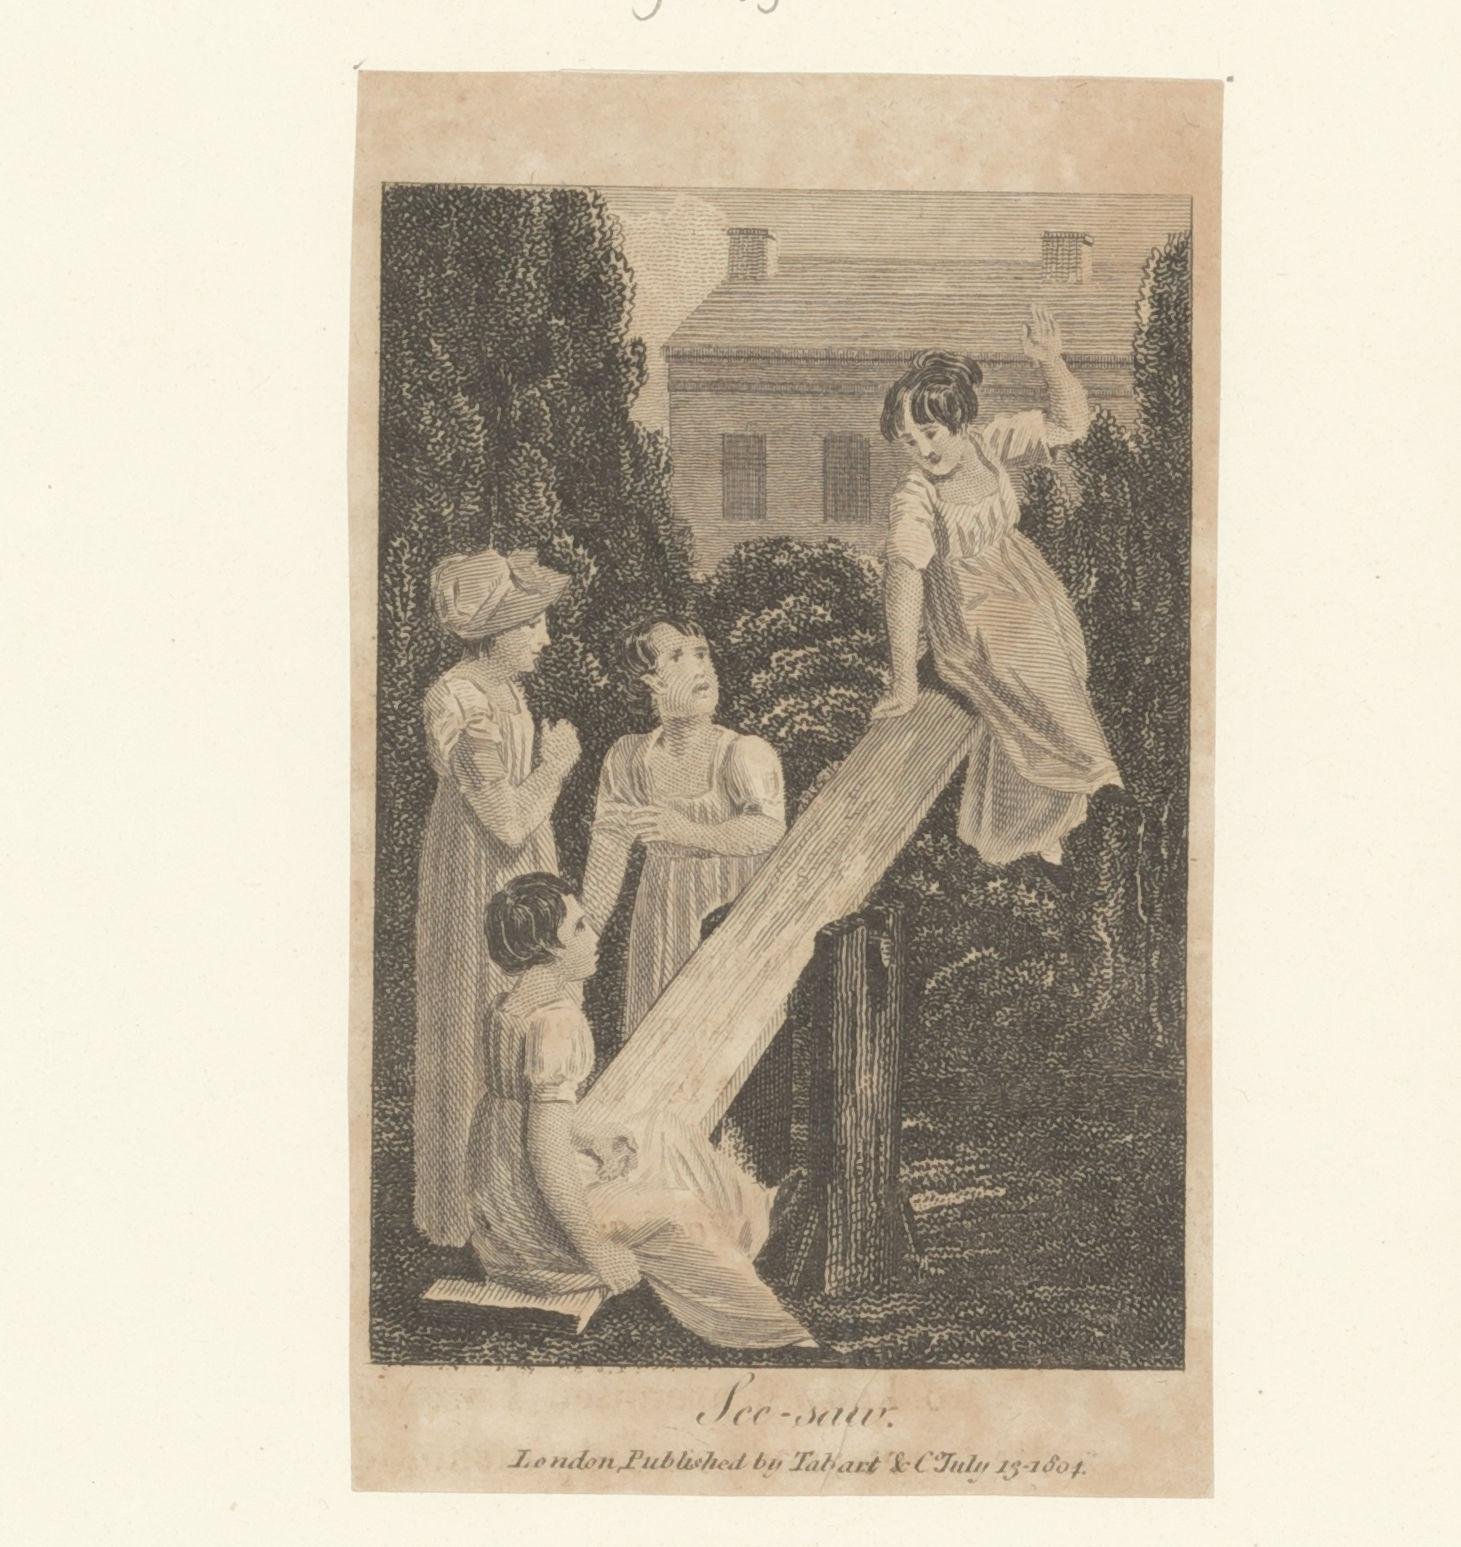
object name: print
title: See-saw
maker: Anonymous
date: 1812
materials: paper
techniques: engraving, etching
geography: london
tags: children's games and plays, seesaw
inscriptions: collector's mark: Lugt 1641, stamp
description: Onderwerpsrubrieken binnen de Atlas Zeden en Gewoonten: Zeden en Gewoonten in Engeren Zin, Des menschen beging, midden en einde, Kinderleven – Kinderspel en Kinderprenten.